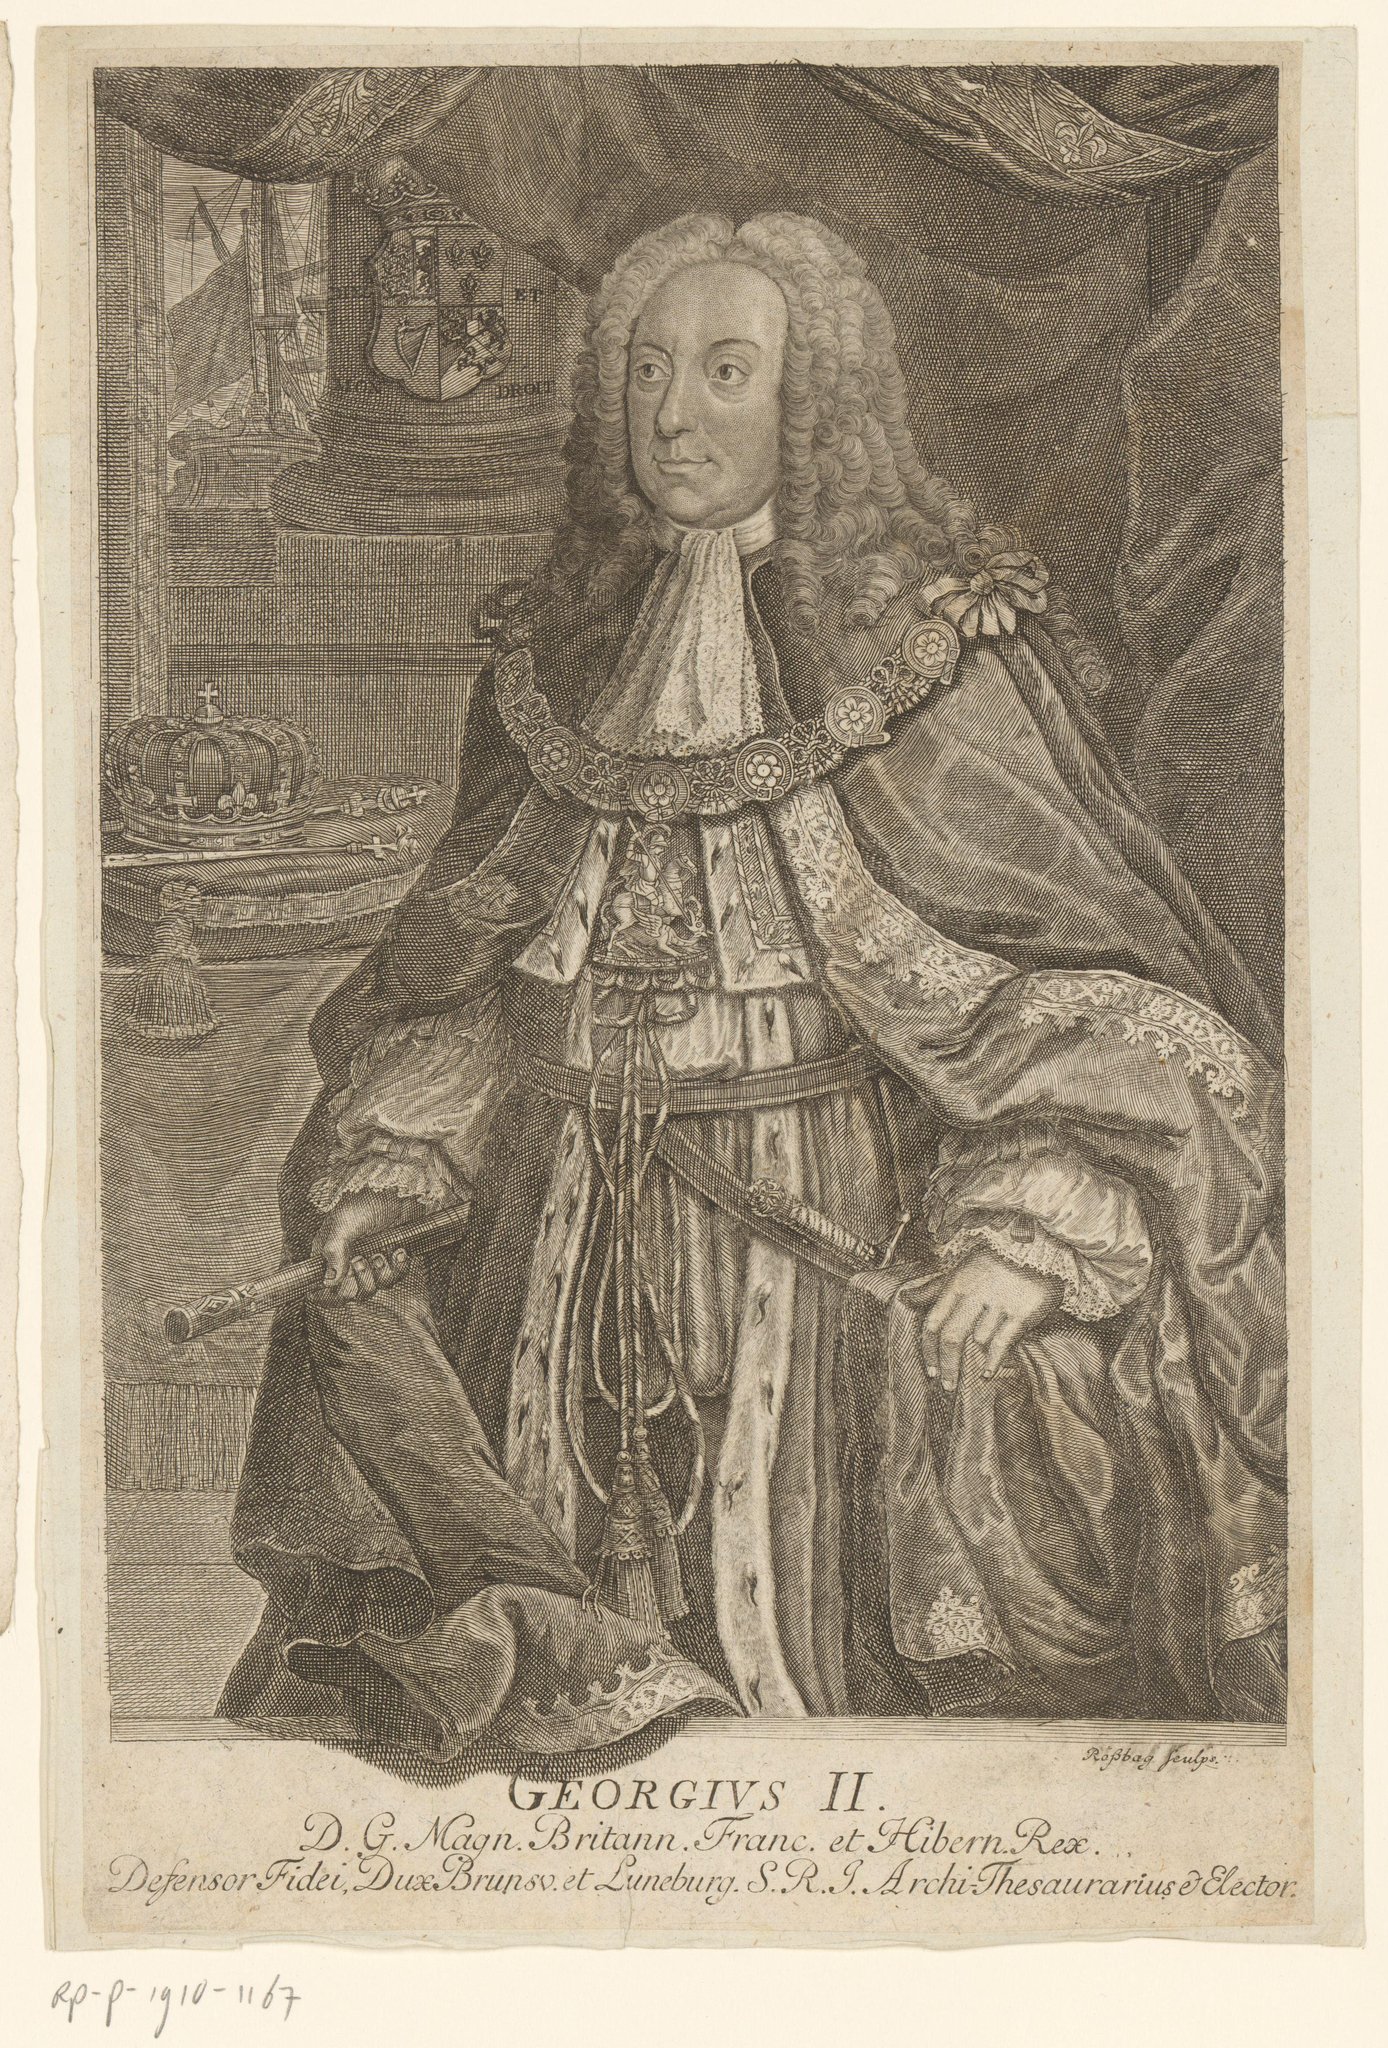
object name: print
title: Portret van George II, koning van Groot-Brittannië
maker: johann friedrich rosbach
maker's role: print maker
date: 1727-1749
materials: paper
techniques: engraving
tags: london, historical persons, ships (in general), armorial bearing, heraldry, insignia and symbols of sovereignty (crown, diadem, sceptre, orb, seal, standard, cloak, pectoral)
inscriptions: collector's mark: Lugt 2228